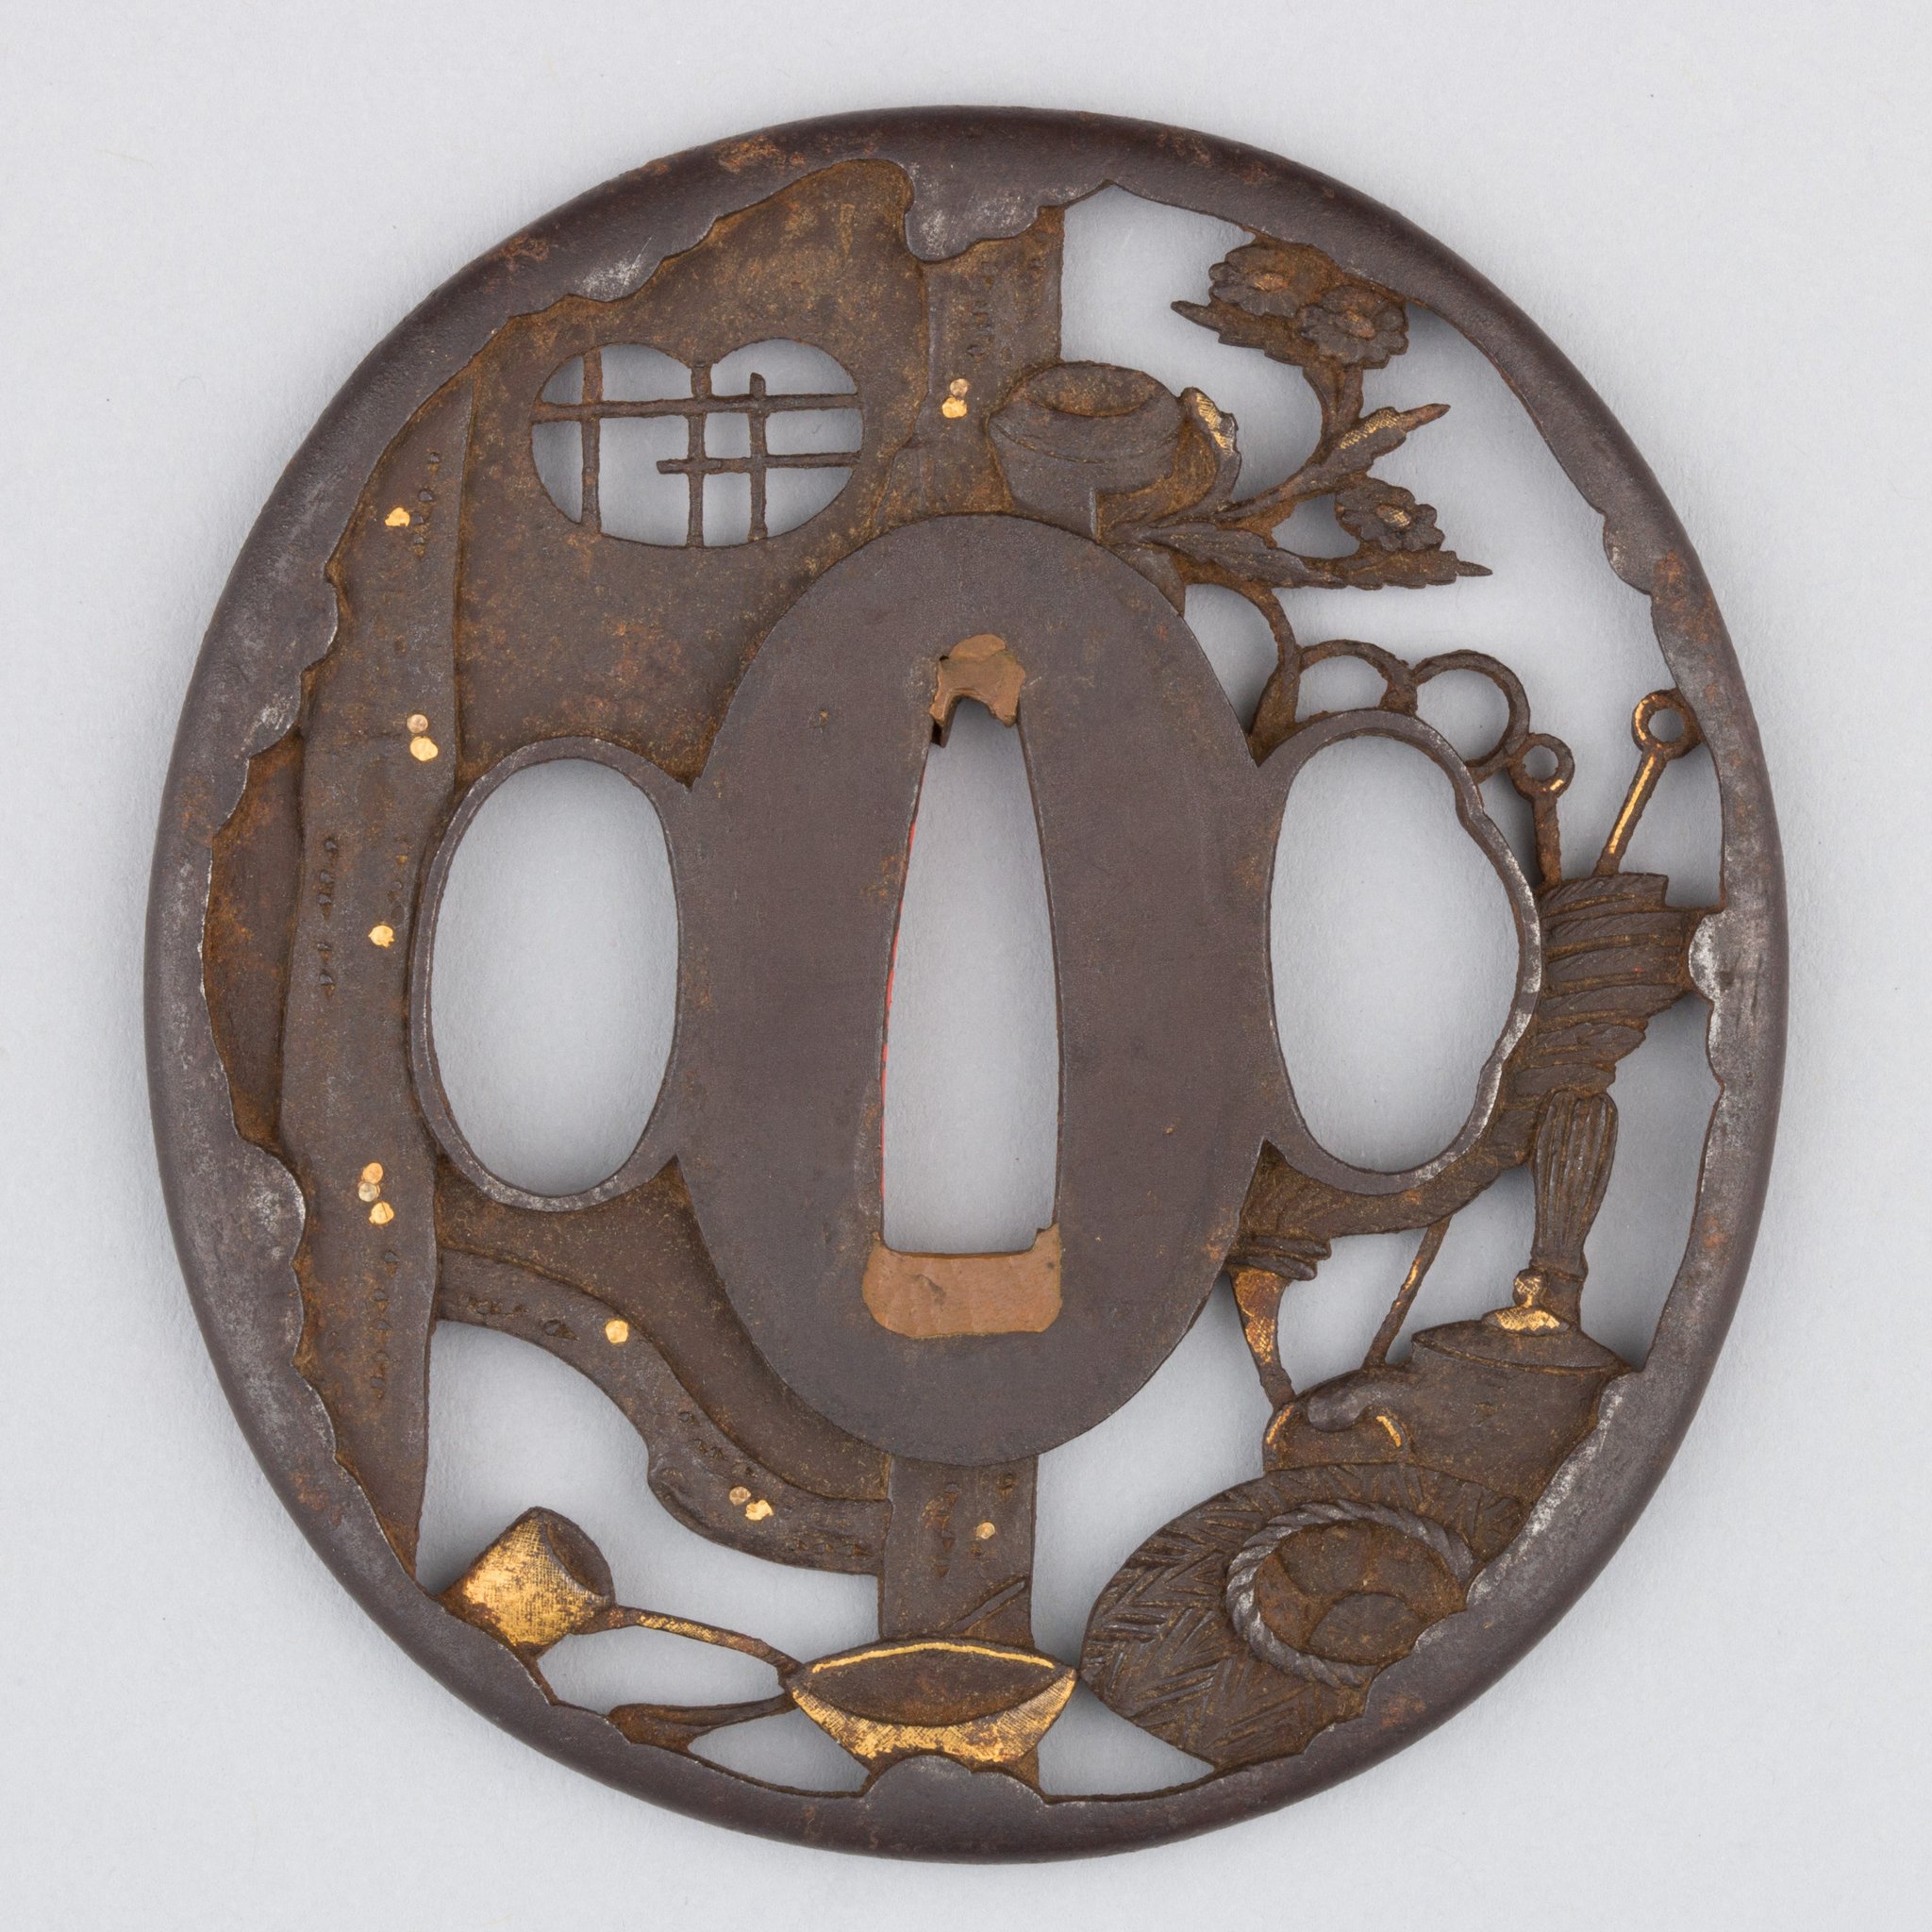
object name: sword guard tsuba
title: Sword Guard (Tsuba)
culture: japanese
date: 1615-1868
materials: copper, gold, iron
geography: japan